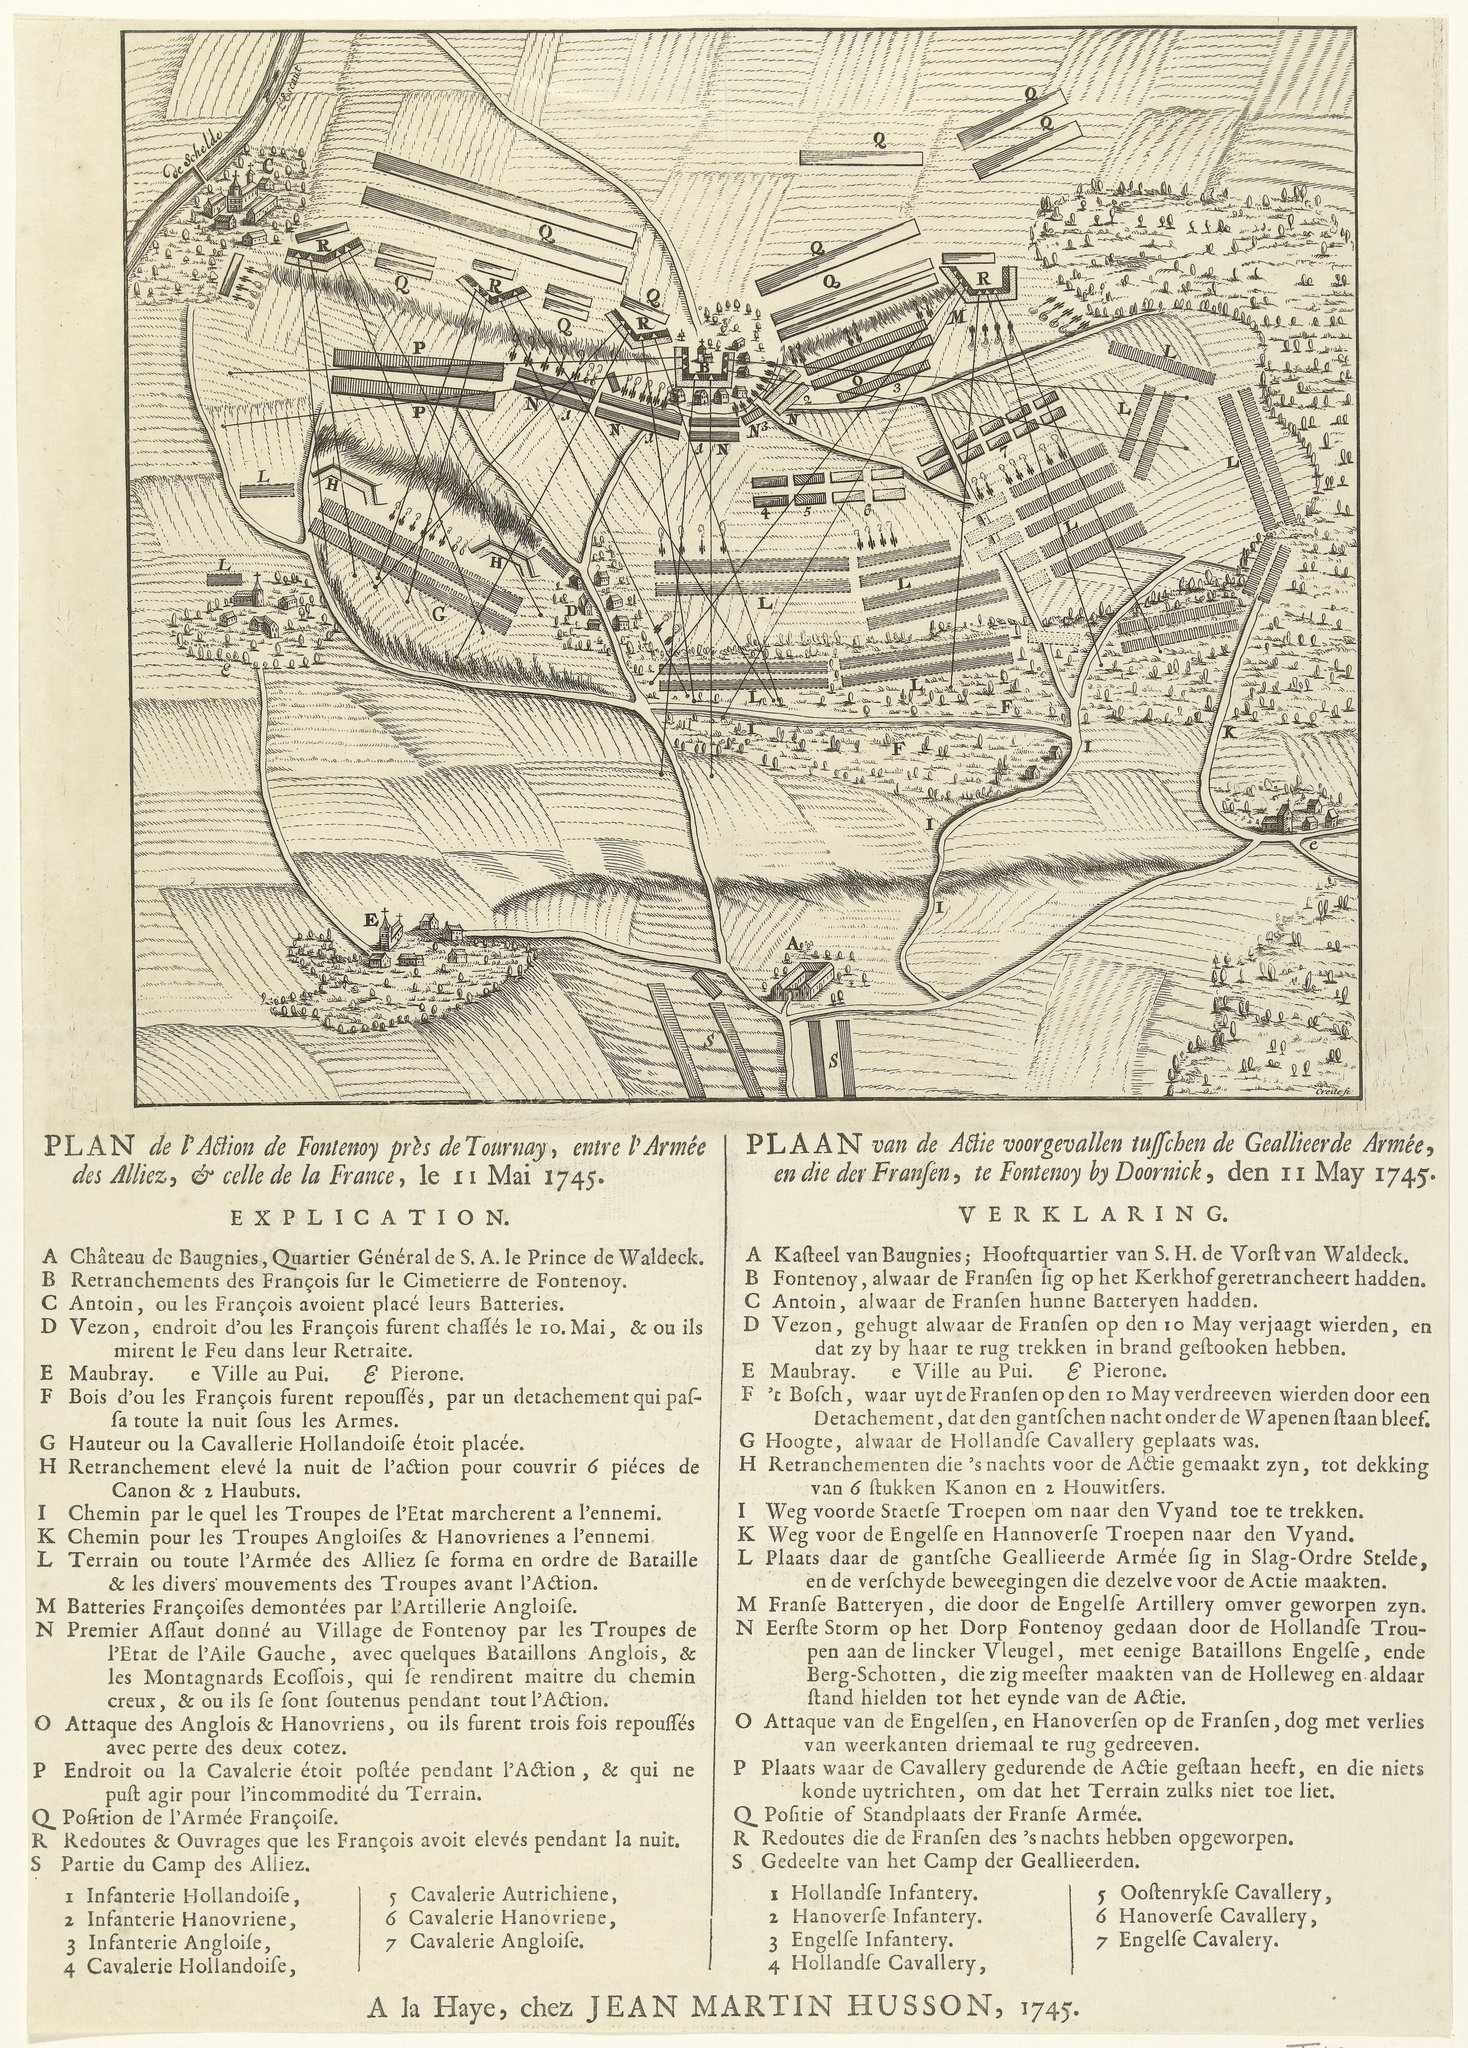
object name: print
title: Plan de l'Action de Fontenoy près de Tournay, entre l'Armée des Alliez, & celle de la France, le 11 Mai 1745 / Plaan van de Actie voorgevallen tusschen de Geallieerde Armée, en die der Fransen, te Fontenoy by Doornick, den 11 May 1745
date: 1745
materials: paper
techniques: etching, letterpress printing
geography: the hague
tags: battle (+ land forces)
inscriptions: collector's mark: Lugt 2228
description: Plattegrond van de slag bij Fontenoy (bij Doornik) op 11 mei 1745 tussen het Geallieerde leger en de Fransen. Op het blad onder de plaat de verklaringen A-S en 1-7 in het Frans en Nederlands.